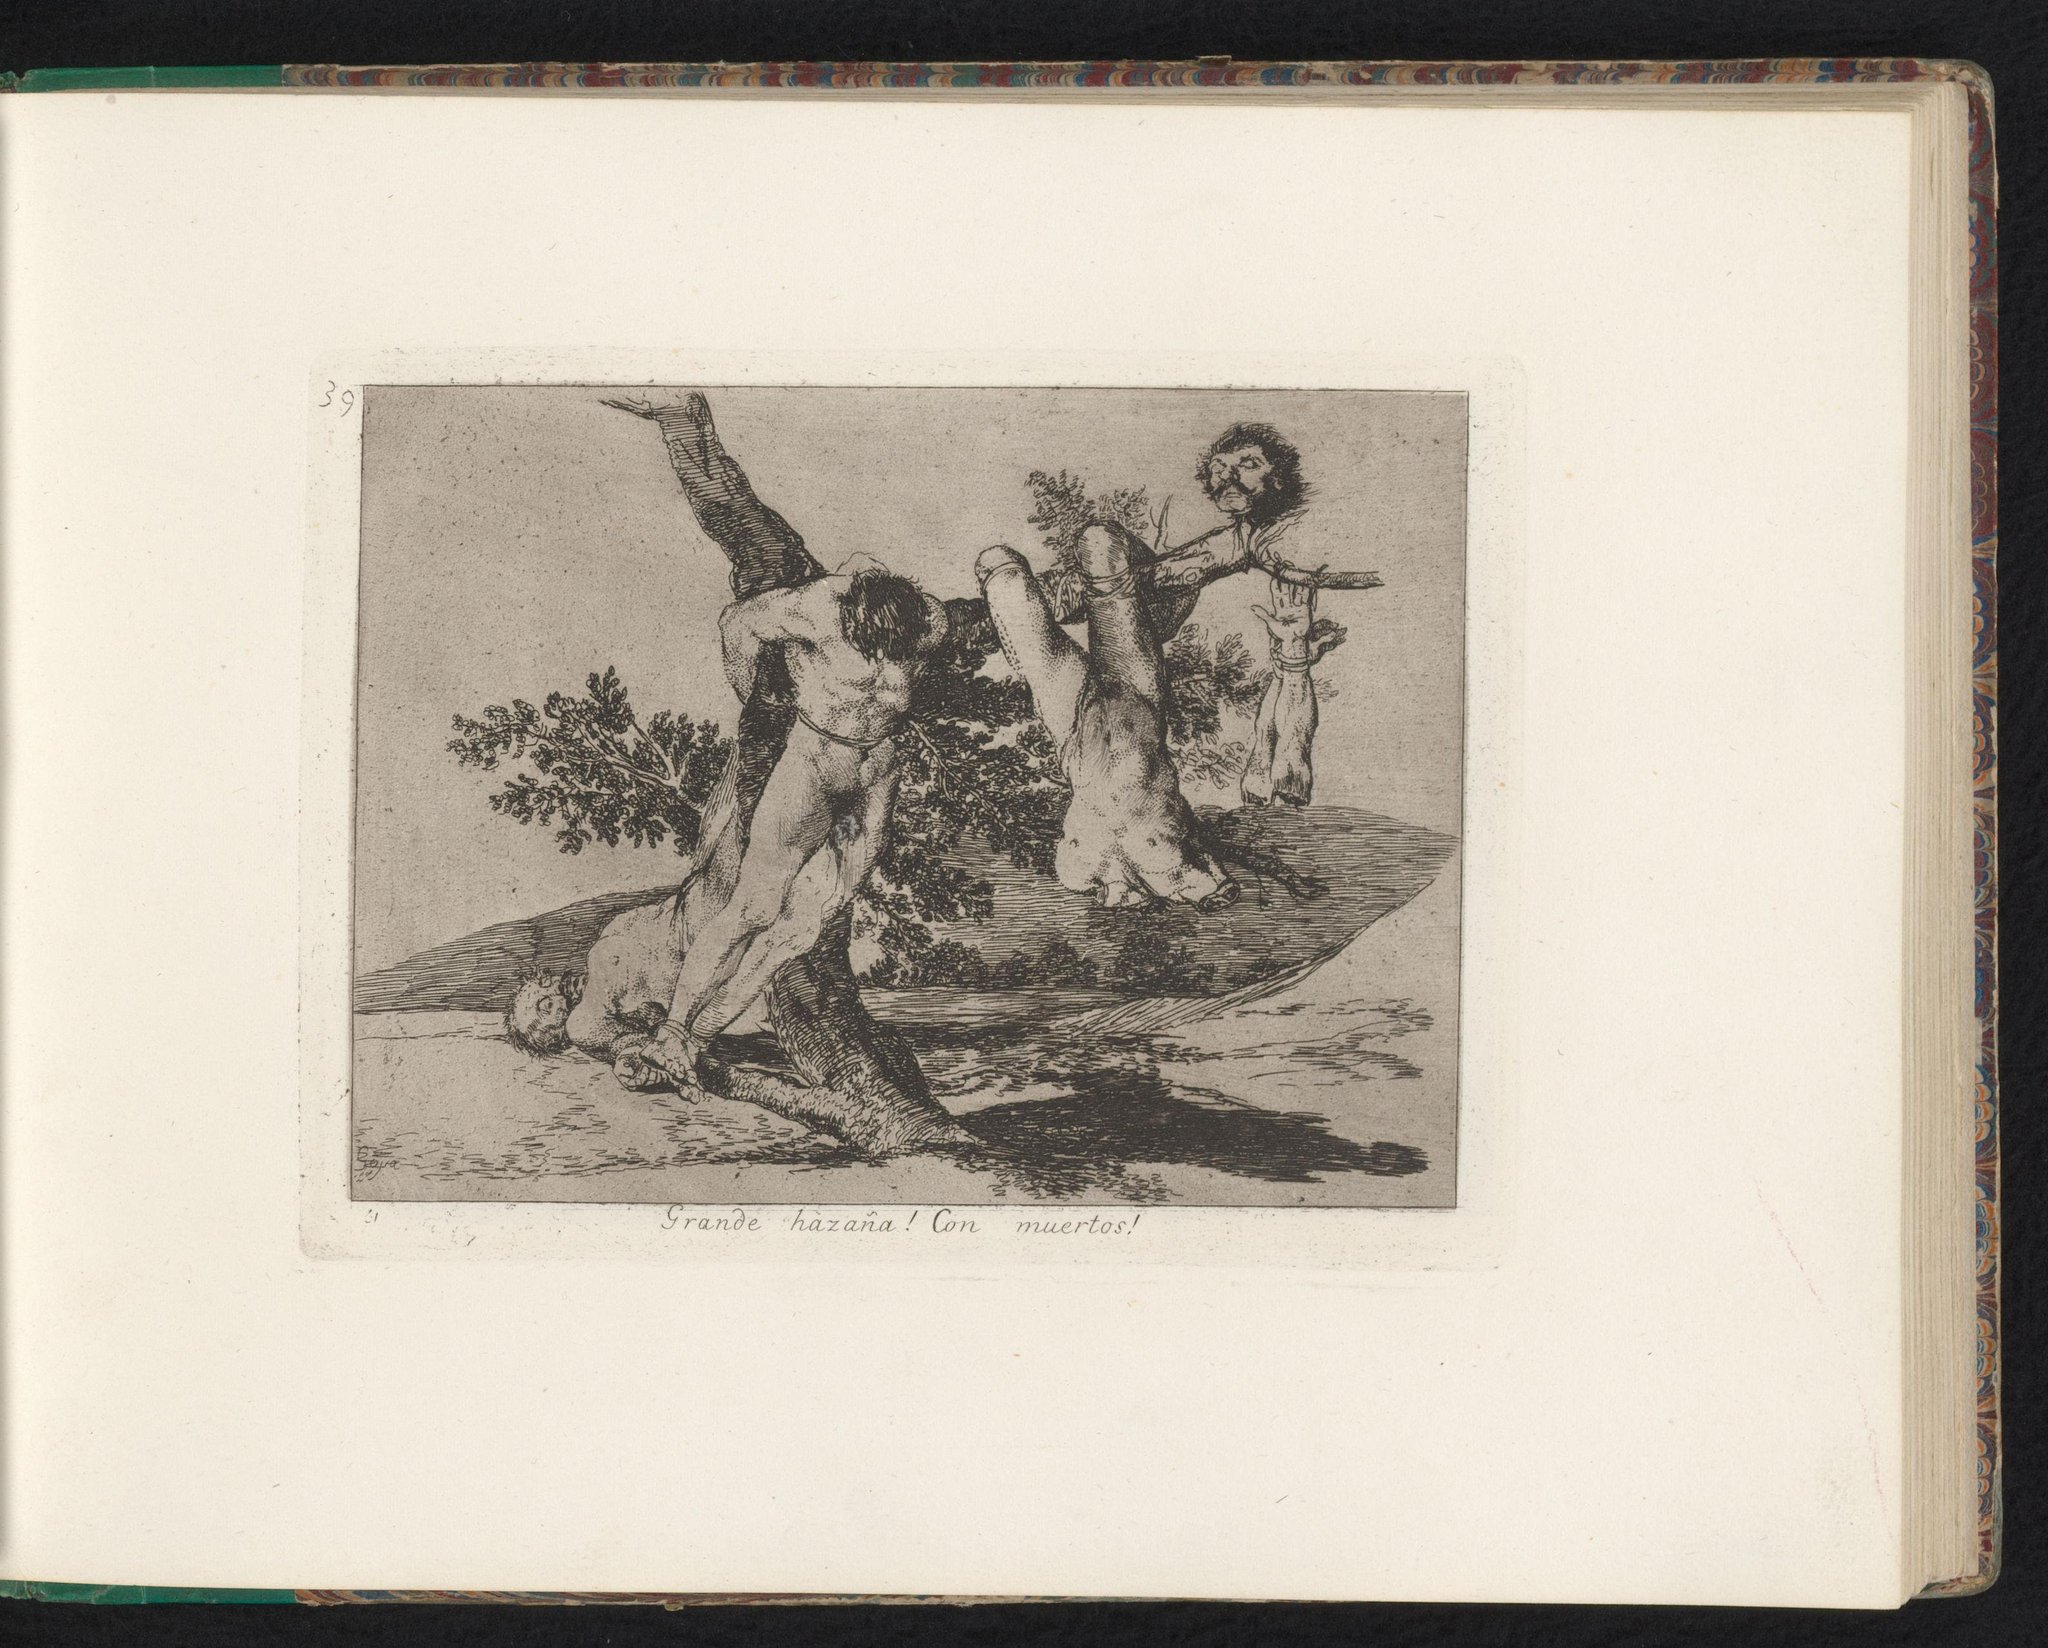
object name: print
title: Grande hazaña! Con muertos!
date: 1810-1820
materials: paper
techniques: aquatint, drypoint, etching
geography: madrid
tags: headless body of a beheaded person, violent death by hanging, horrors of war, head of a beheaded person on post or pole, spain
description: Deze prent maakt deel uit van een album.